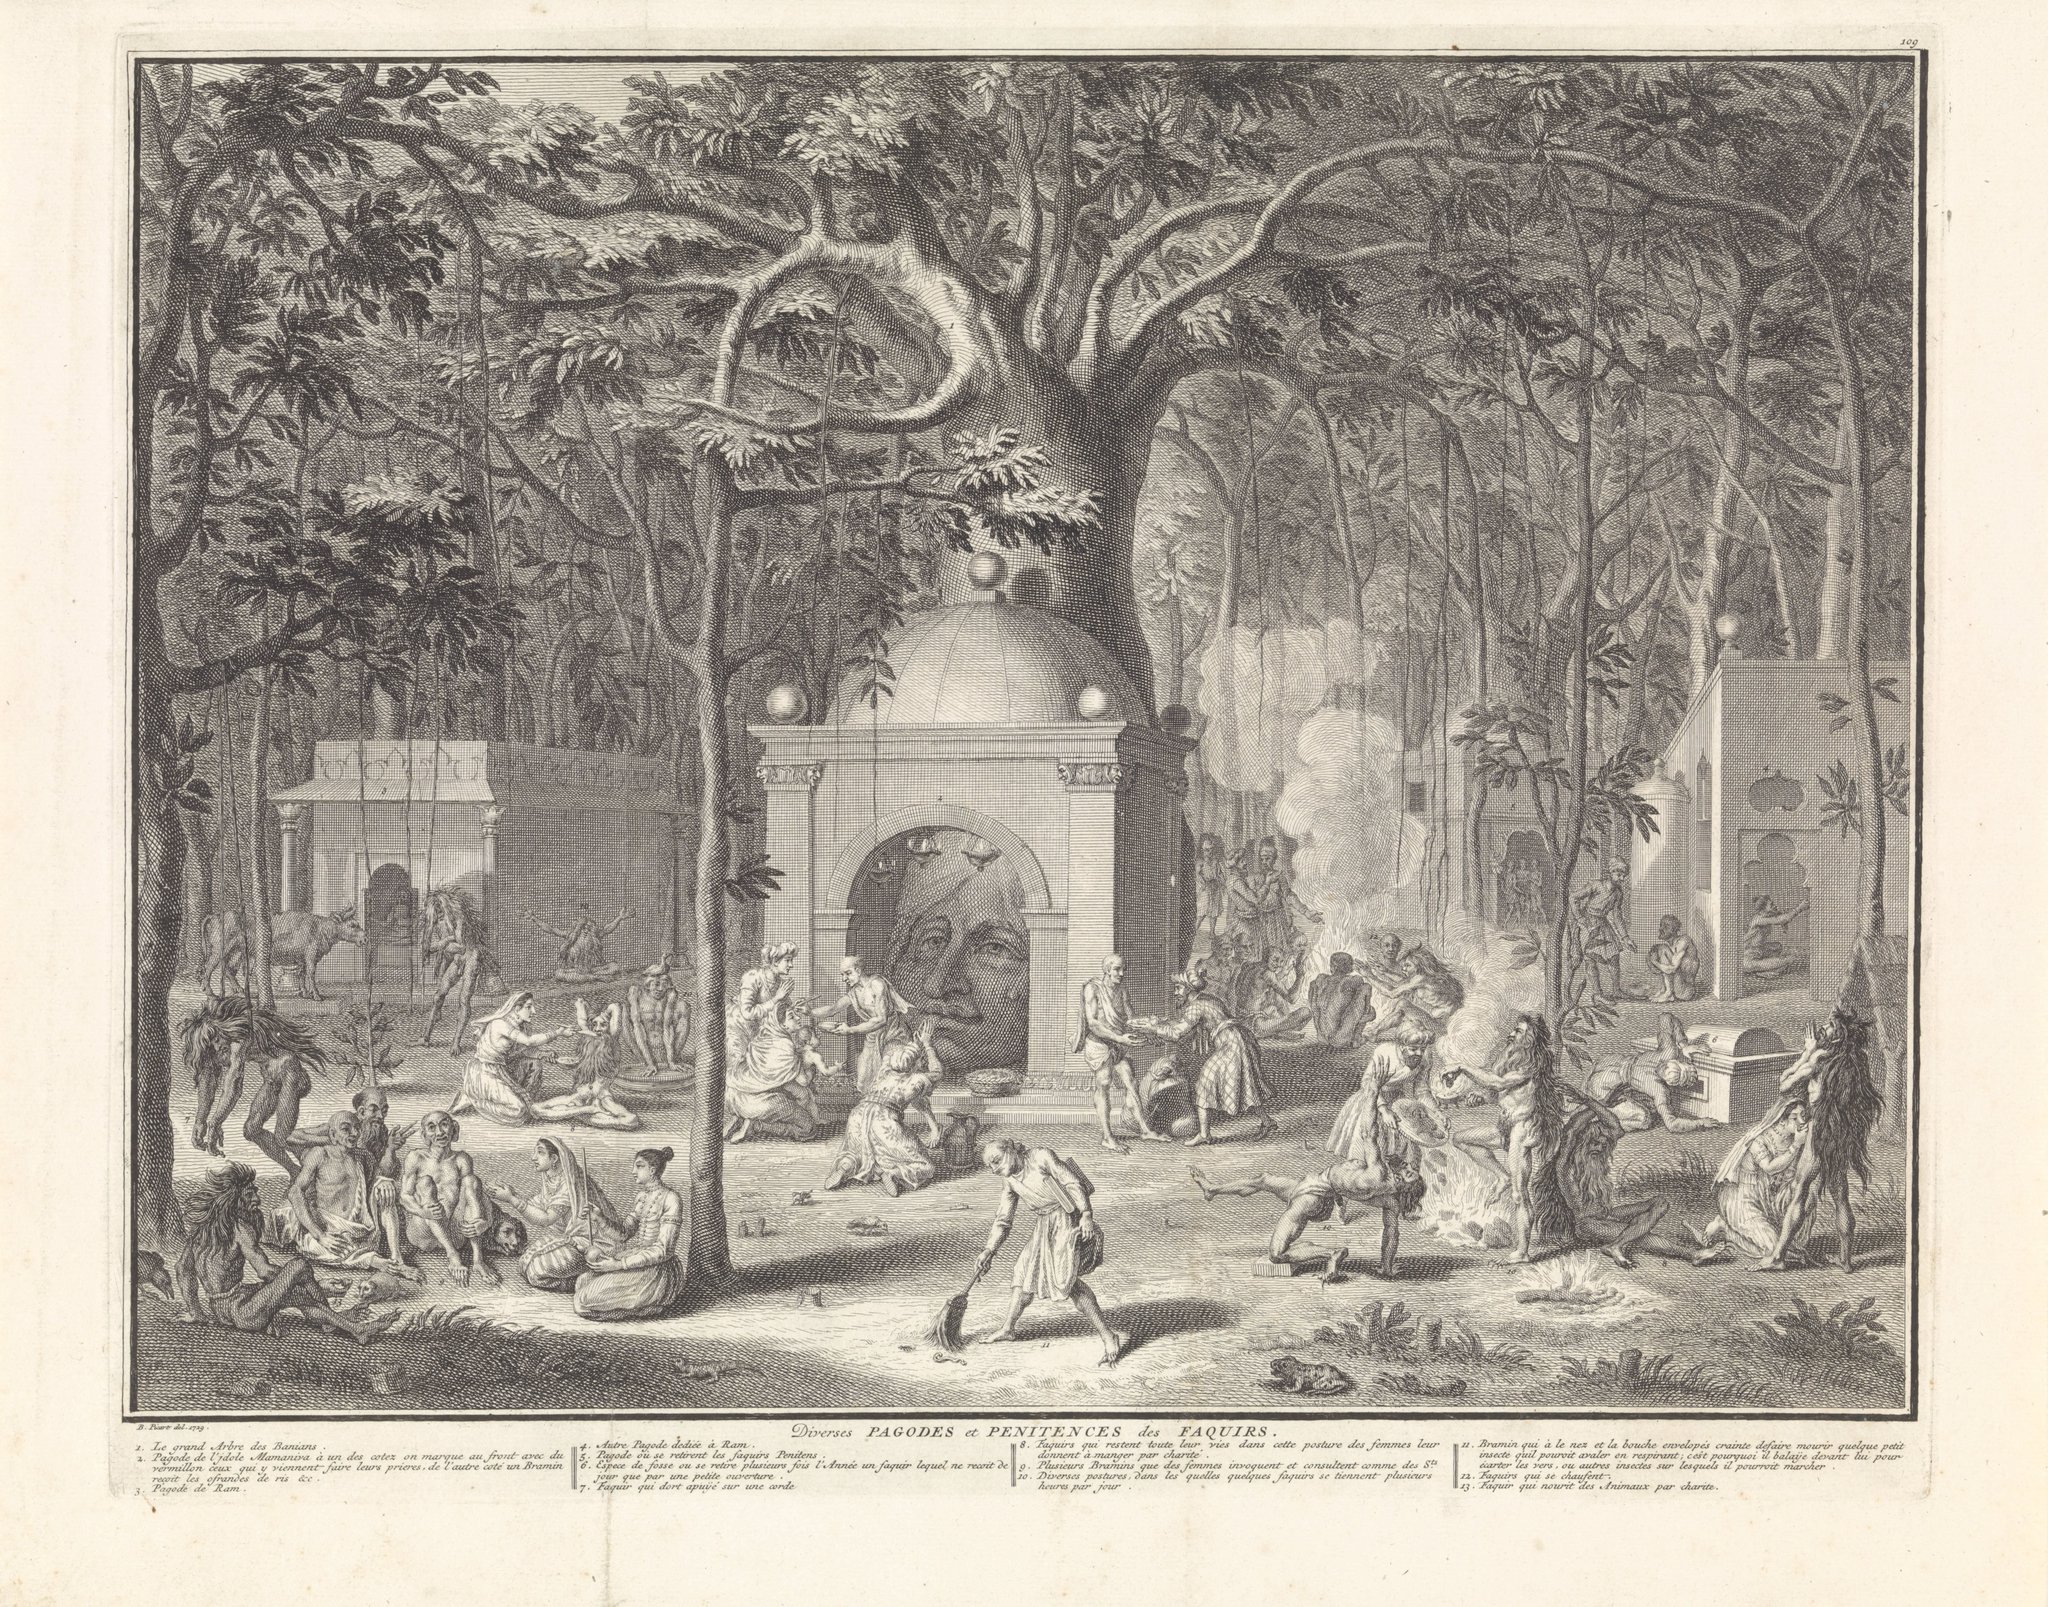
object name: print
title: Oerwoud met Indiase tempels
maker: bernard picart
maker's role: draughtsman, print maker, publisher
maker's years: 1673-1733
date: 1729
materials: paper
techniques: engraving, etching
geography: amsterdam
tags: asceticism ~ hinduism, buddhism, jainism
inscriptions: collector's mark: Lugt 2228, collector's mark: Lugt 2760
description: Prent gebruikt in en mogelijk gebruikt in andere edities van: Picart, Bernard. Ceremonies et coutumes religieuses des peuples idolatres: Part 1, section 1. Amsterdam: Jean Frederic Bernard, 1723, na p. 8.